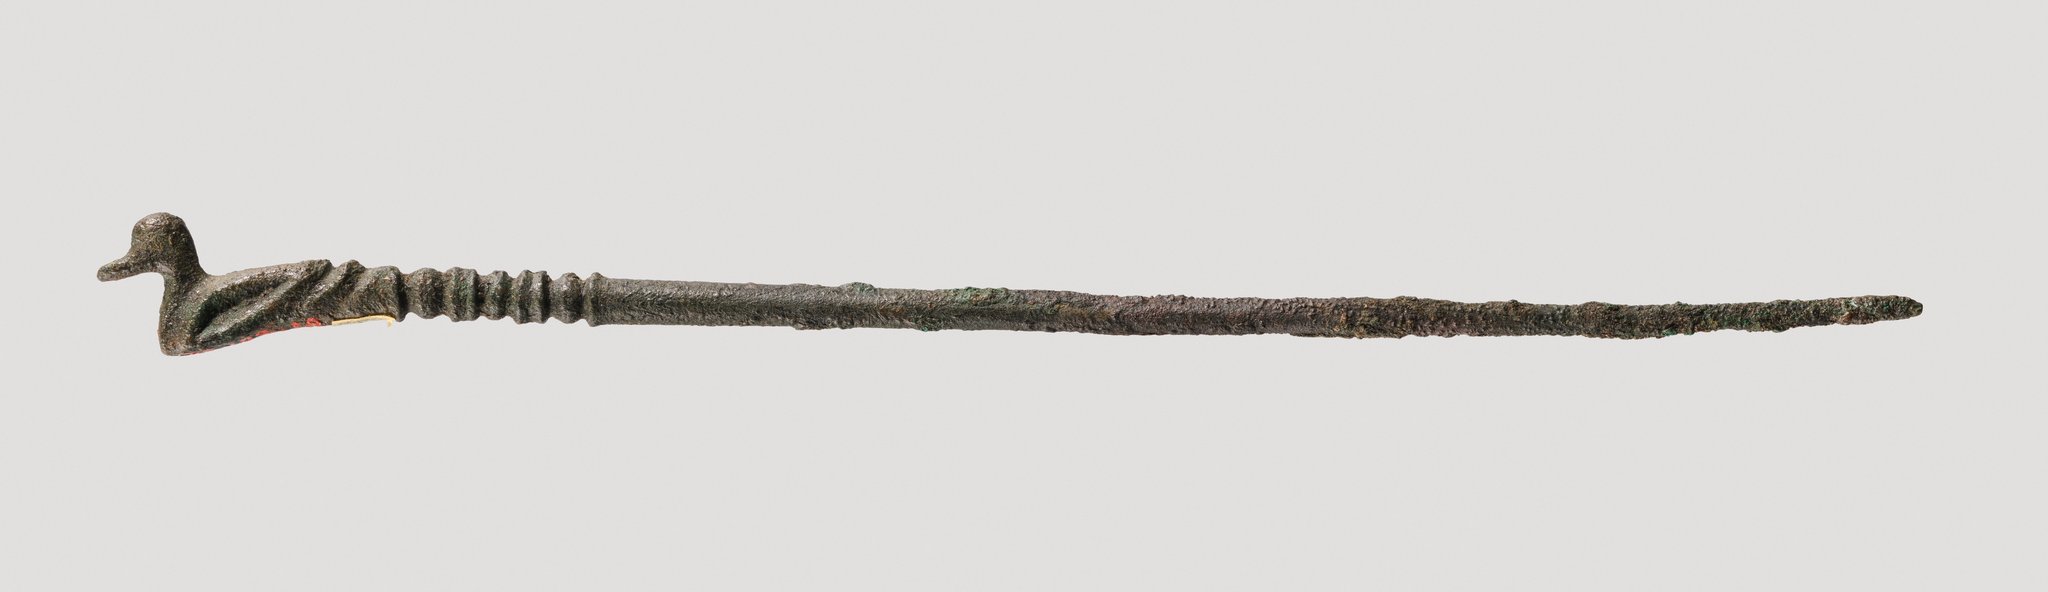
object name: pin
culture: iranian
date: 800-601 BCE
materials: bronze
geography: iran, luristan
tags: birds